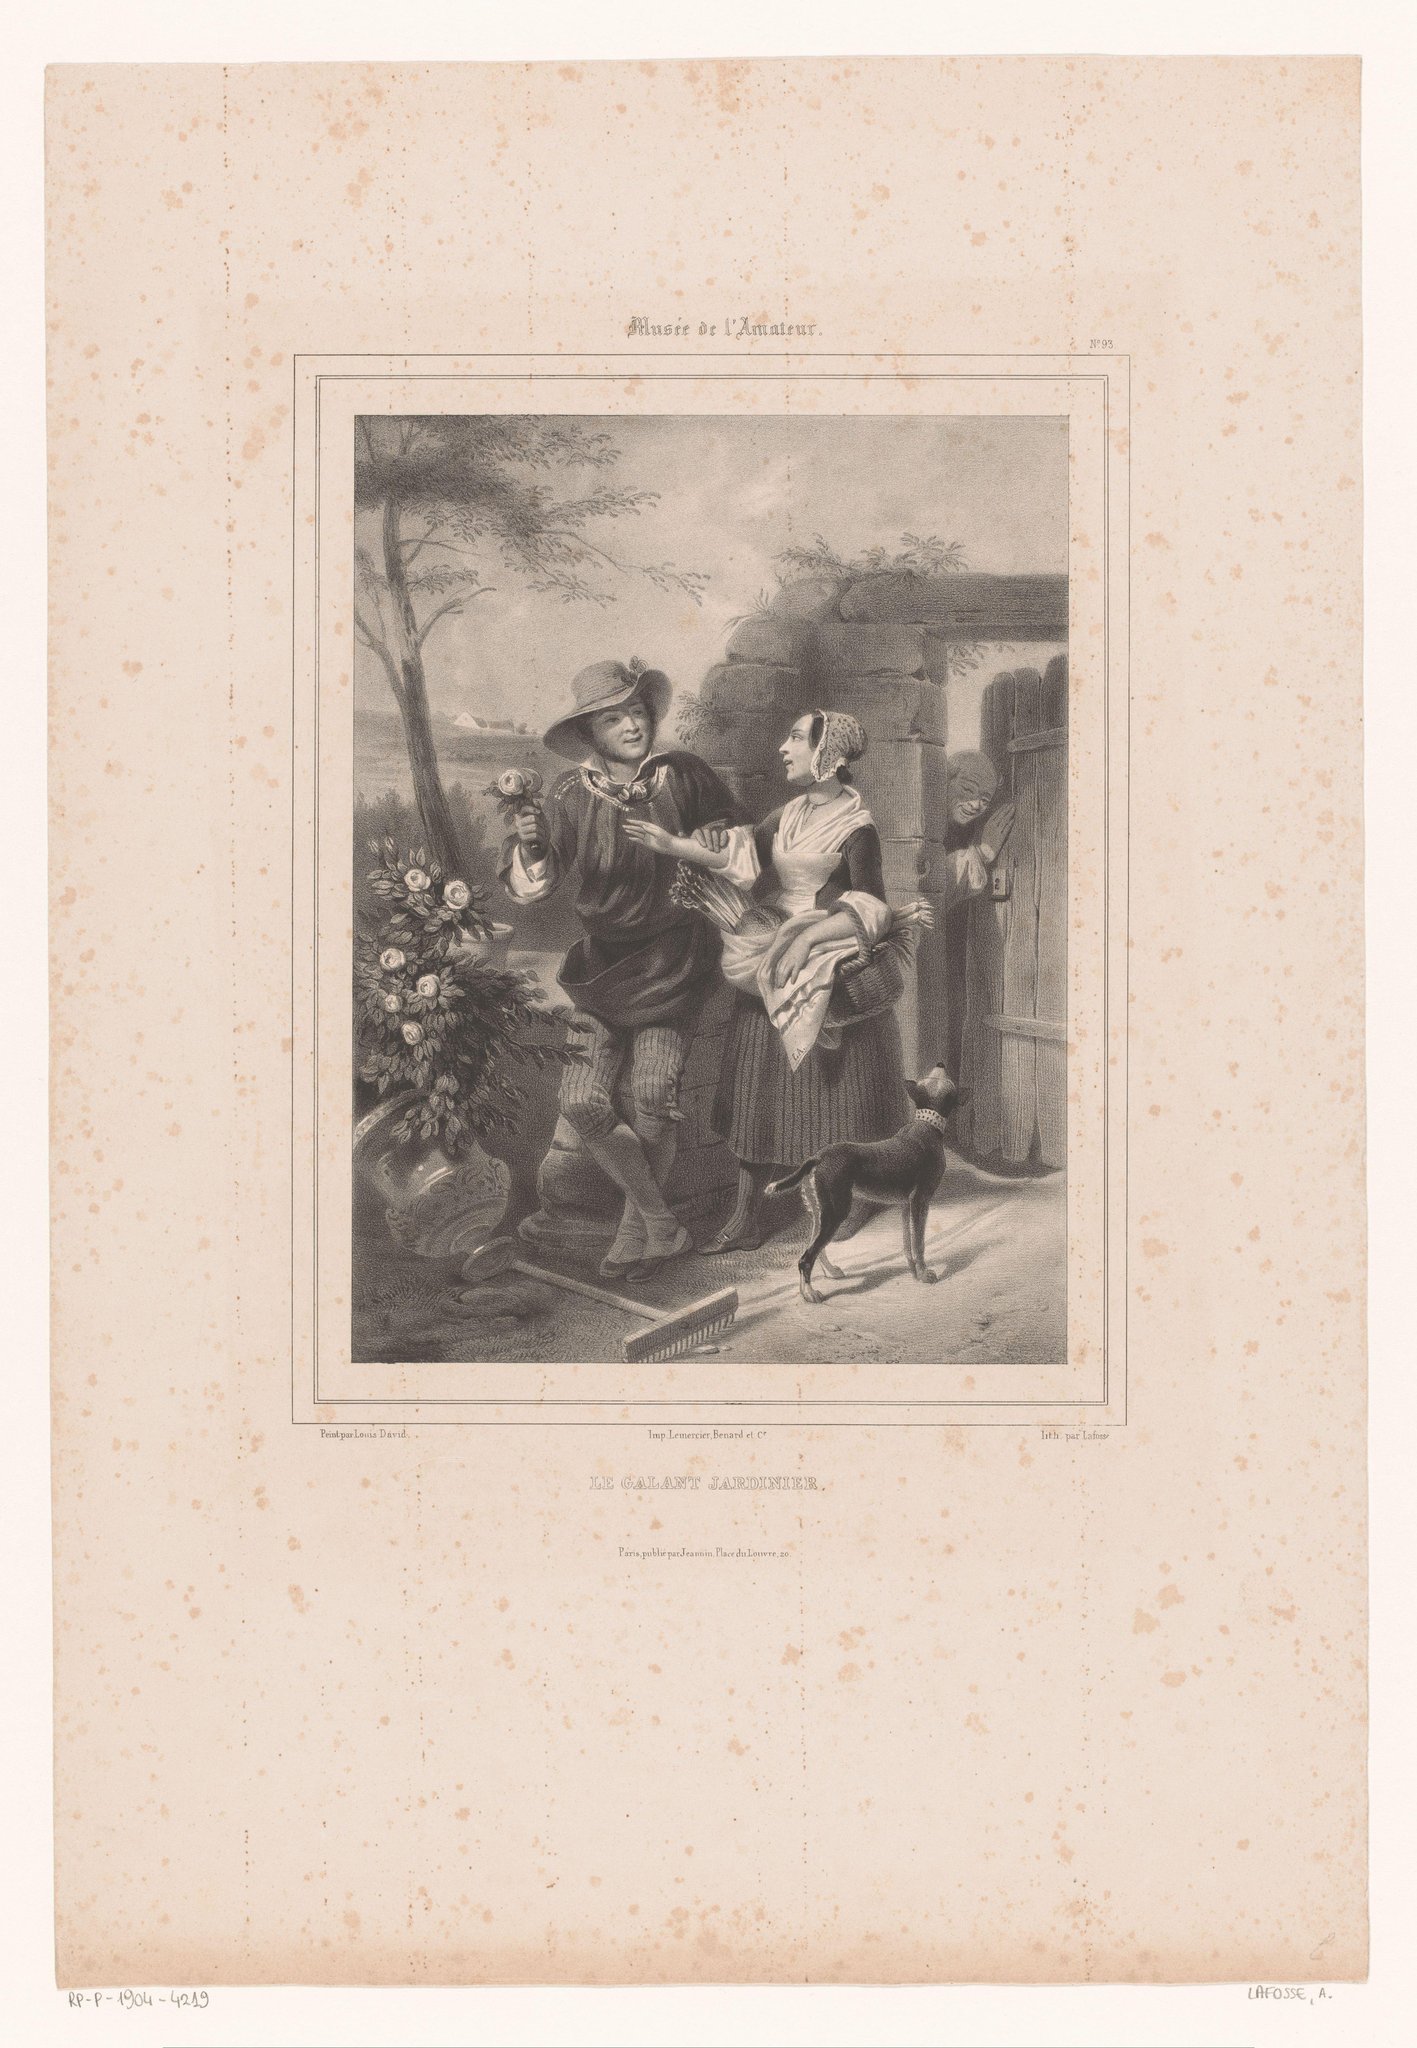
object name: print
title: Tuinman geeft rozen aan een vrouw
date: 1840-1842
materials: paper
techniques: lithograph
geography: paris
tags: gardening, flowers: rose, presents offered to the beloved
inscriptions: collector's mark: Lugt 2228a, check stamp: Lugt 1397c